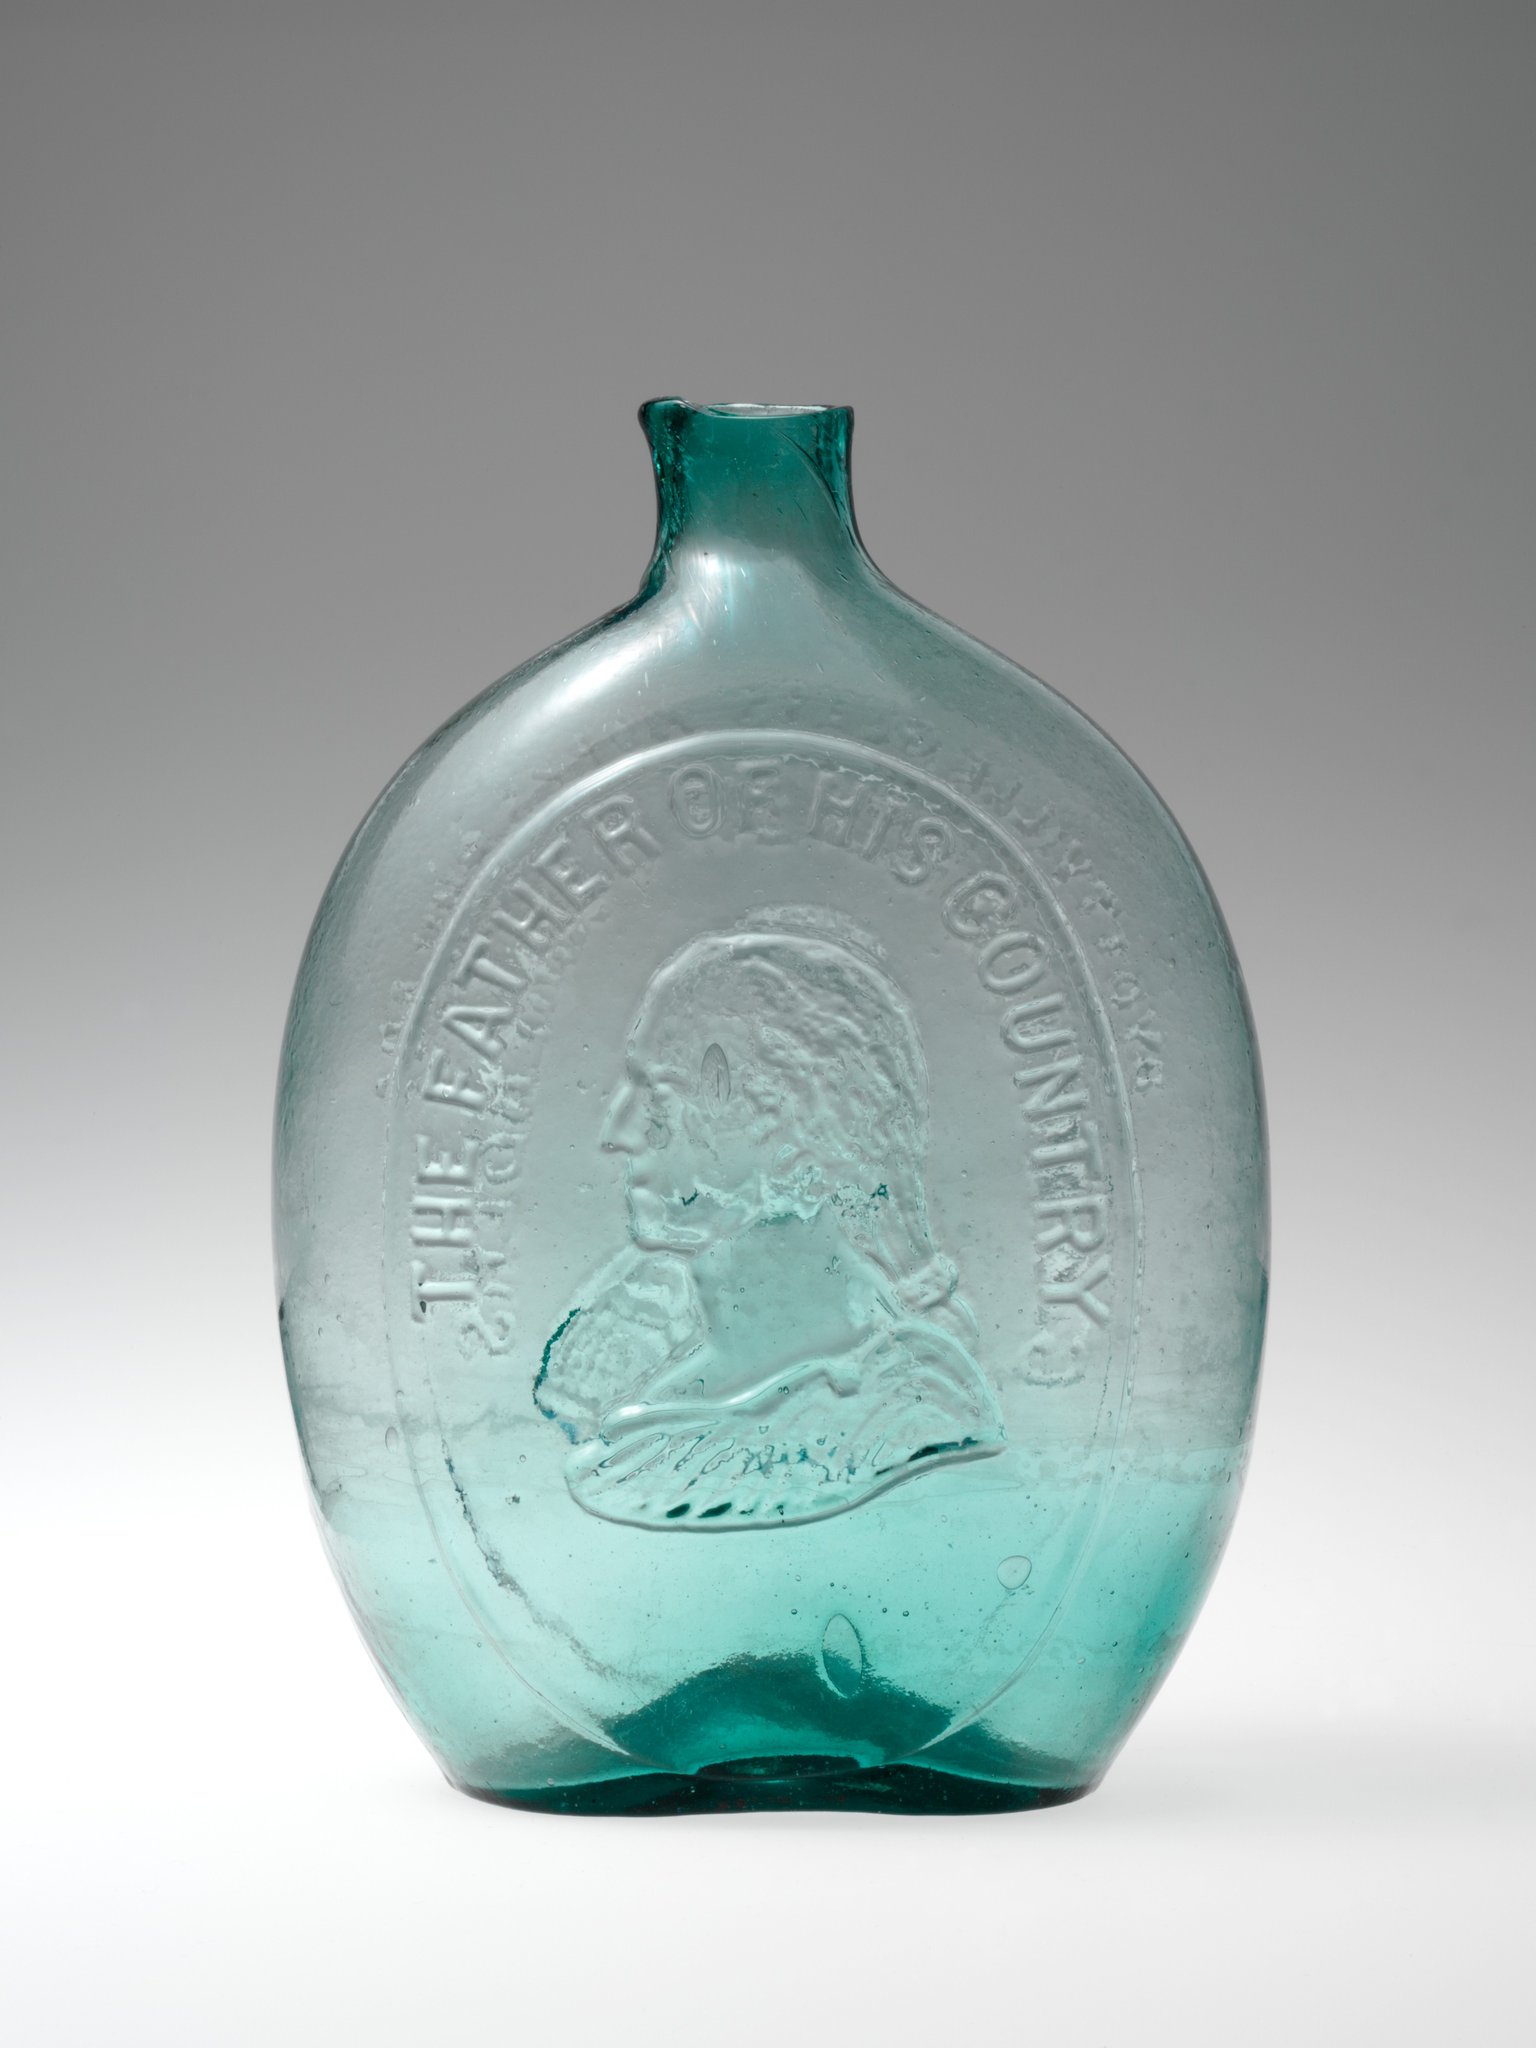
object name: flask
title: Figured flask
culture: american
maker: dyottville glass works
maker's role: manufacturer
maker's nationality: american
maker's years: 1833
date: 1847-1855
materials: glass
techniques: glassblowing, molding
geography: united states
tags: george washington,men